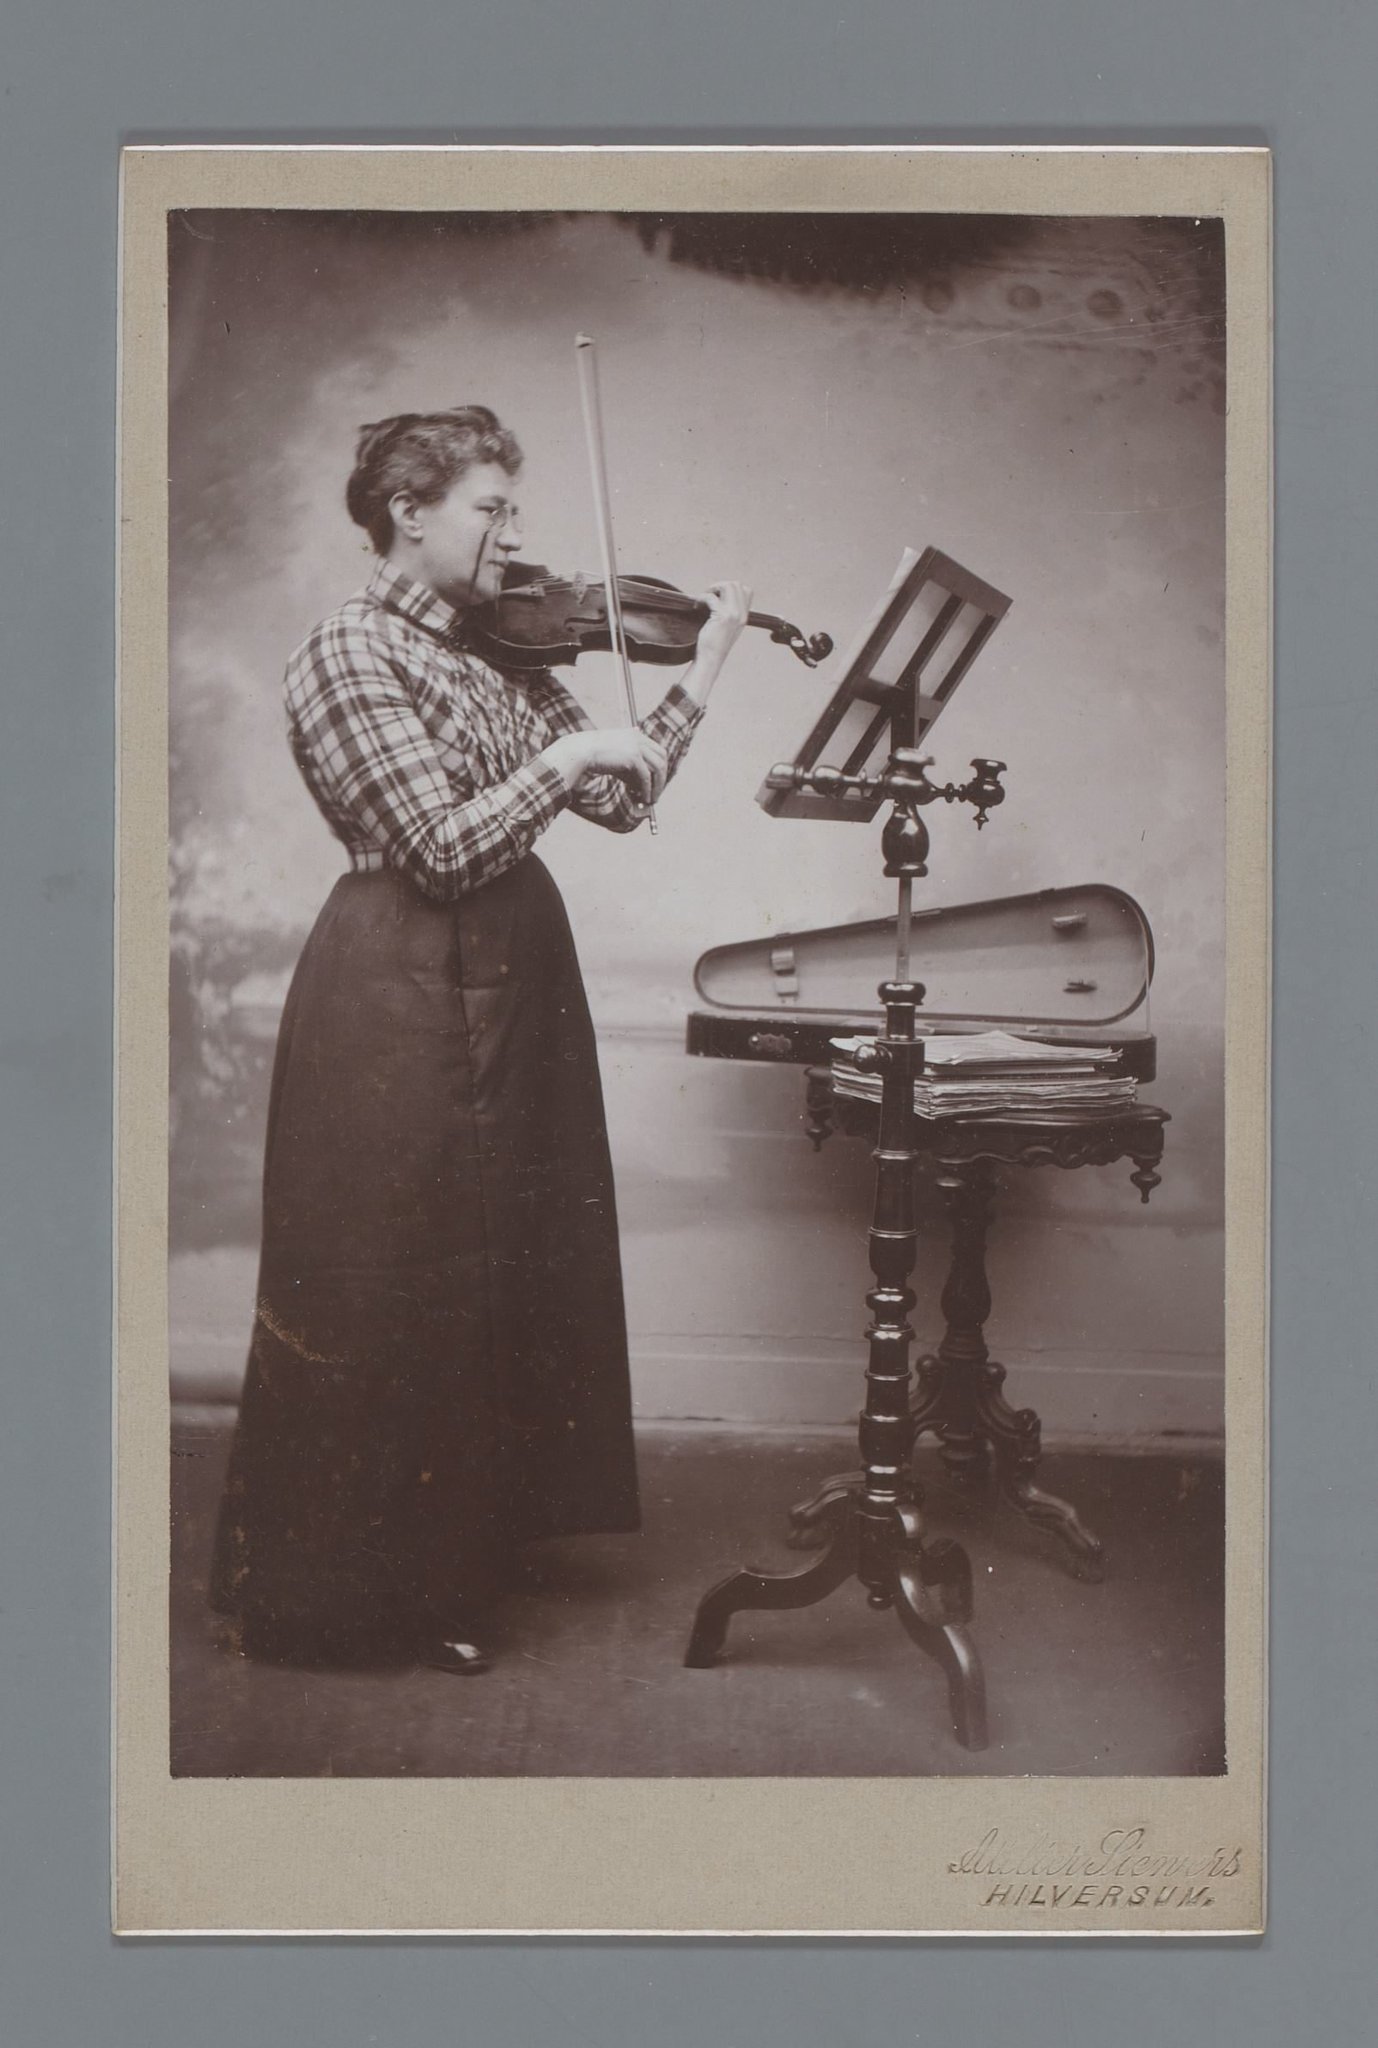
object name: cabinet photograph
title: Portret van een vioolspelende vrouw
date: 1915-1930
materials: cardboard, photographic support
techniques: gelatin silver print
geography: hilversum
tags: violin, fiddle, portrait of a musician